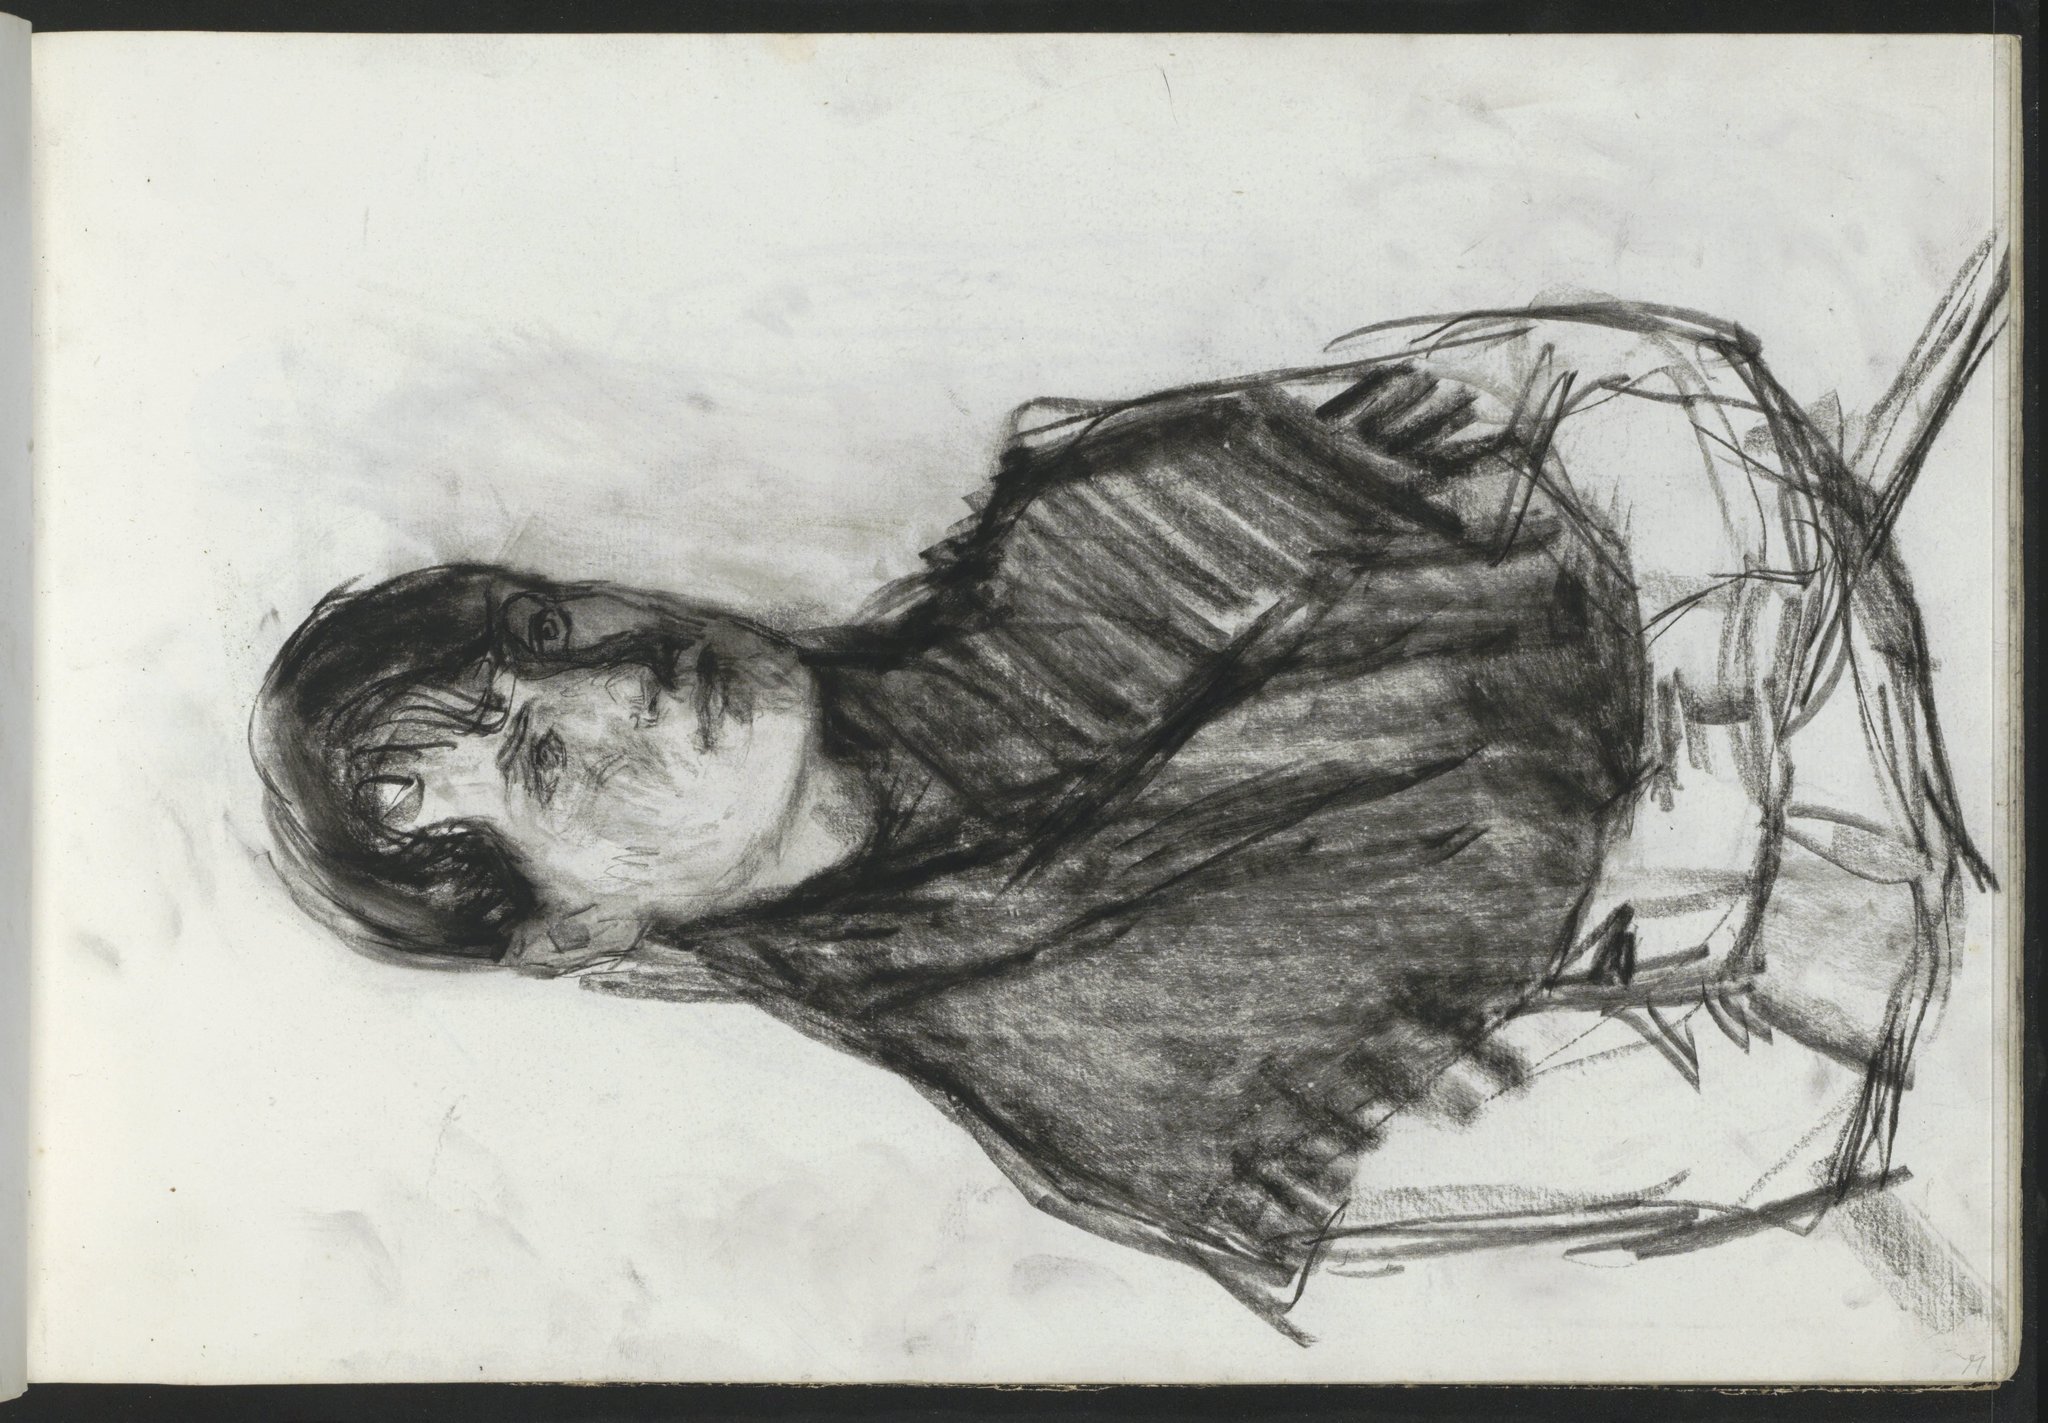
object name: sketchbook leaf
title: Jonge vrouw met haar armen over elkaar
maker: isaac israels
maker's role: draughtsman, painter, print maker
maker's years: 1865-1934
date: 1886-1934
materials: chalk, paper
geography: amsterdam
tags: arms crossed, adolescent, young woman, maiden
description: Om haar schouders een omslagdoek. Blad 7 recto uit schetsboek LXX met 17 bladen.